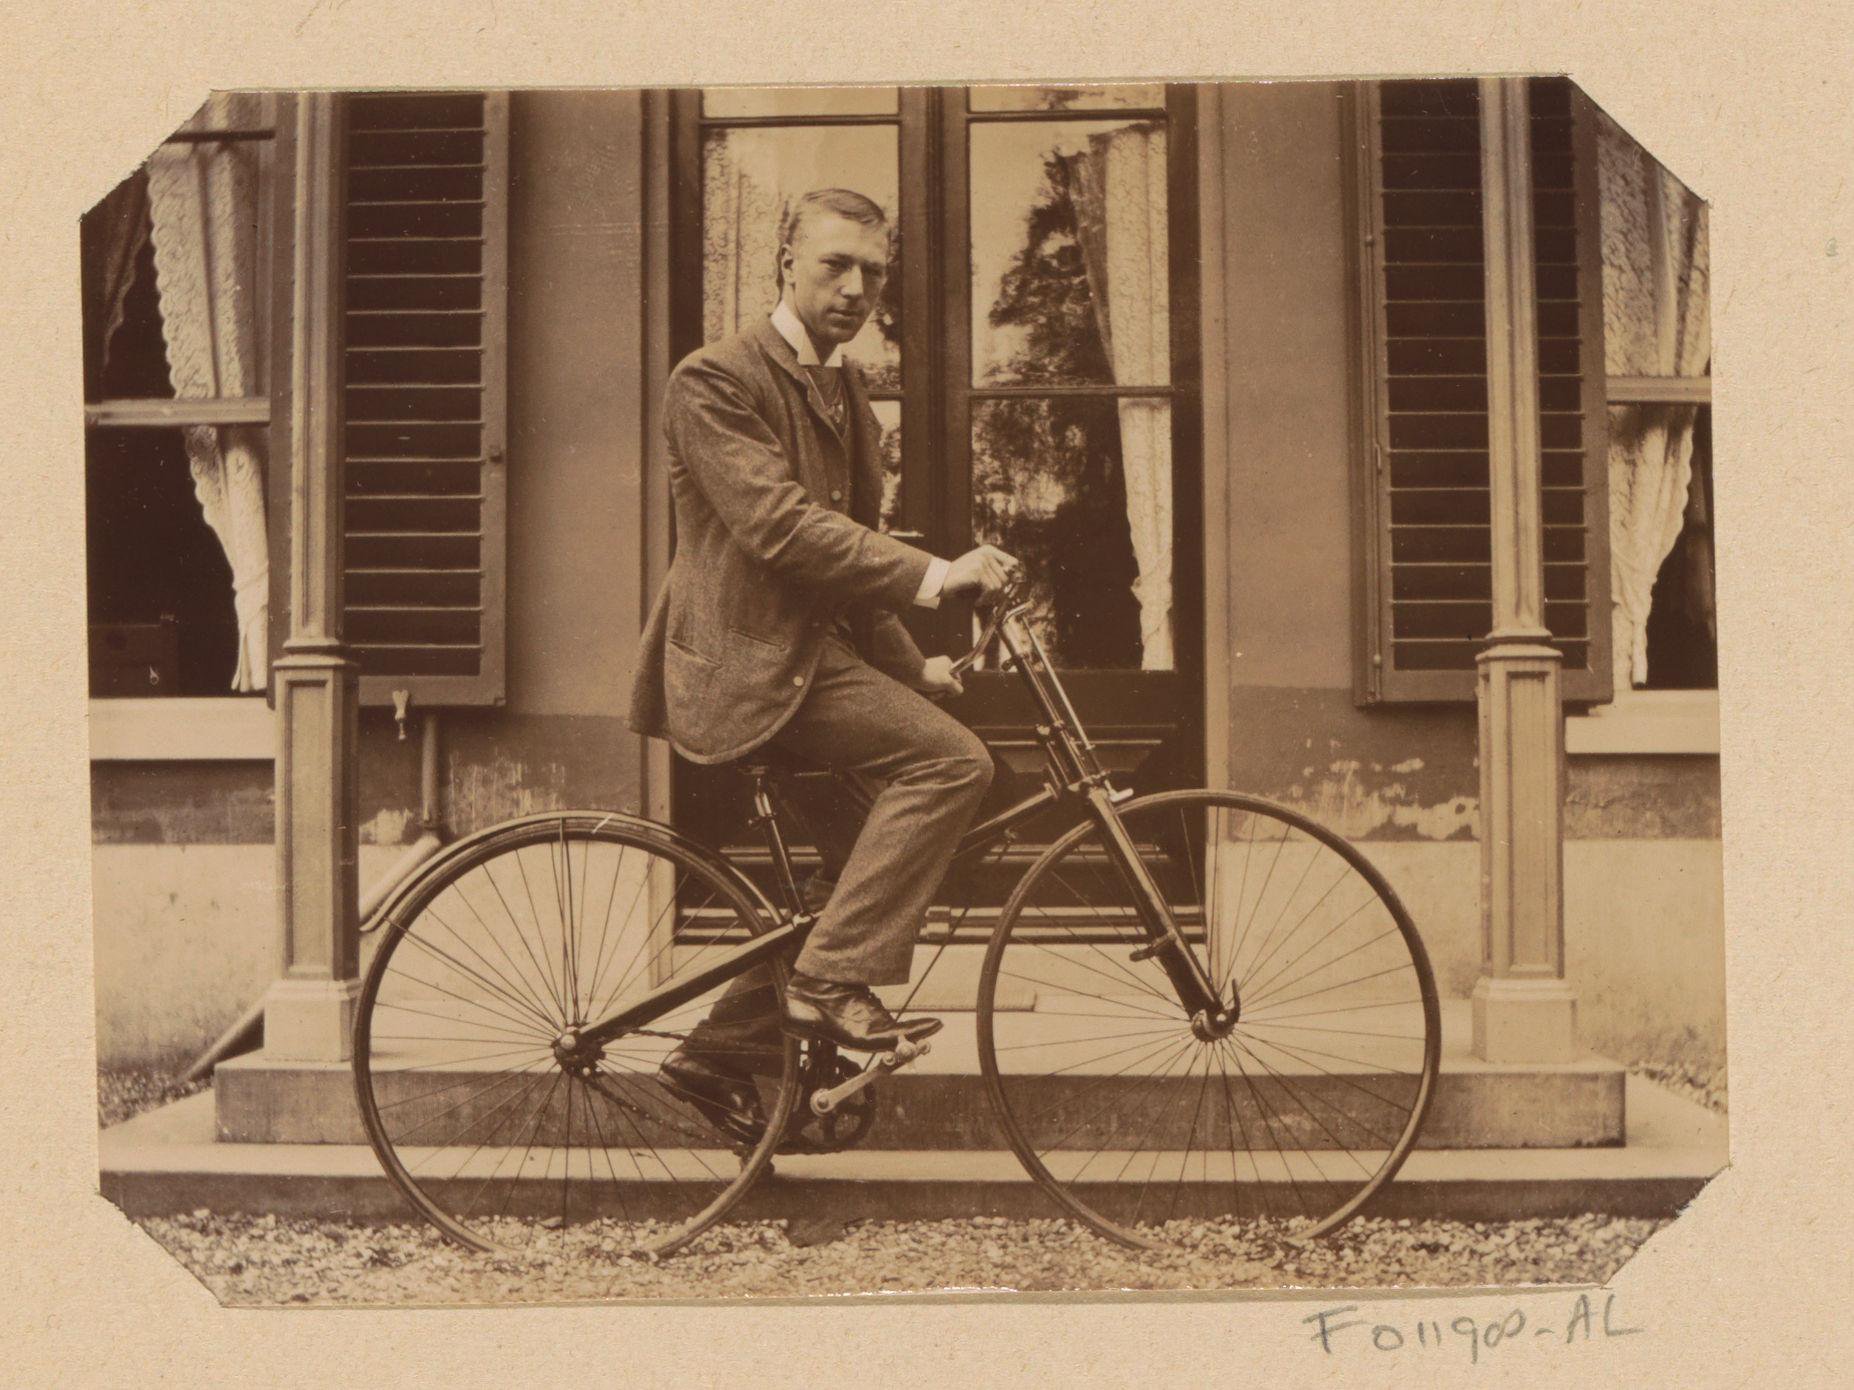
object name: photograph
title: Portret van een onbekende man op een fiets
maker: johanna margaretha piek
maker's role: fotograaf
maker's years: 1870-1947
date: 1889-1893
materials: paper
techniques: gelatin silver print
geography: netherlands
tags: adult man, anonymous historical person portrayed, bicycle, netherlands